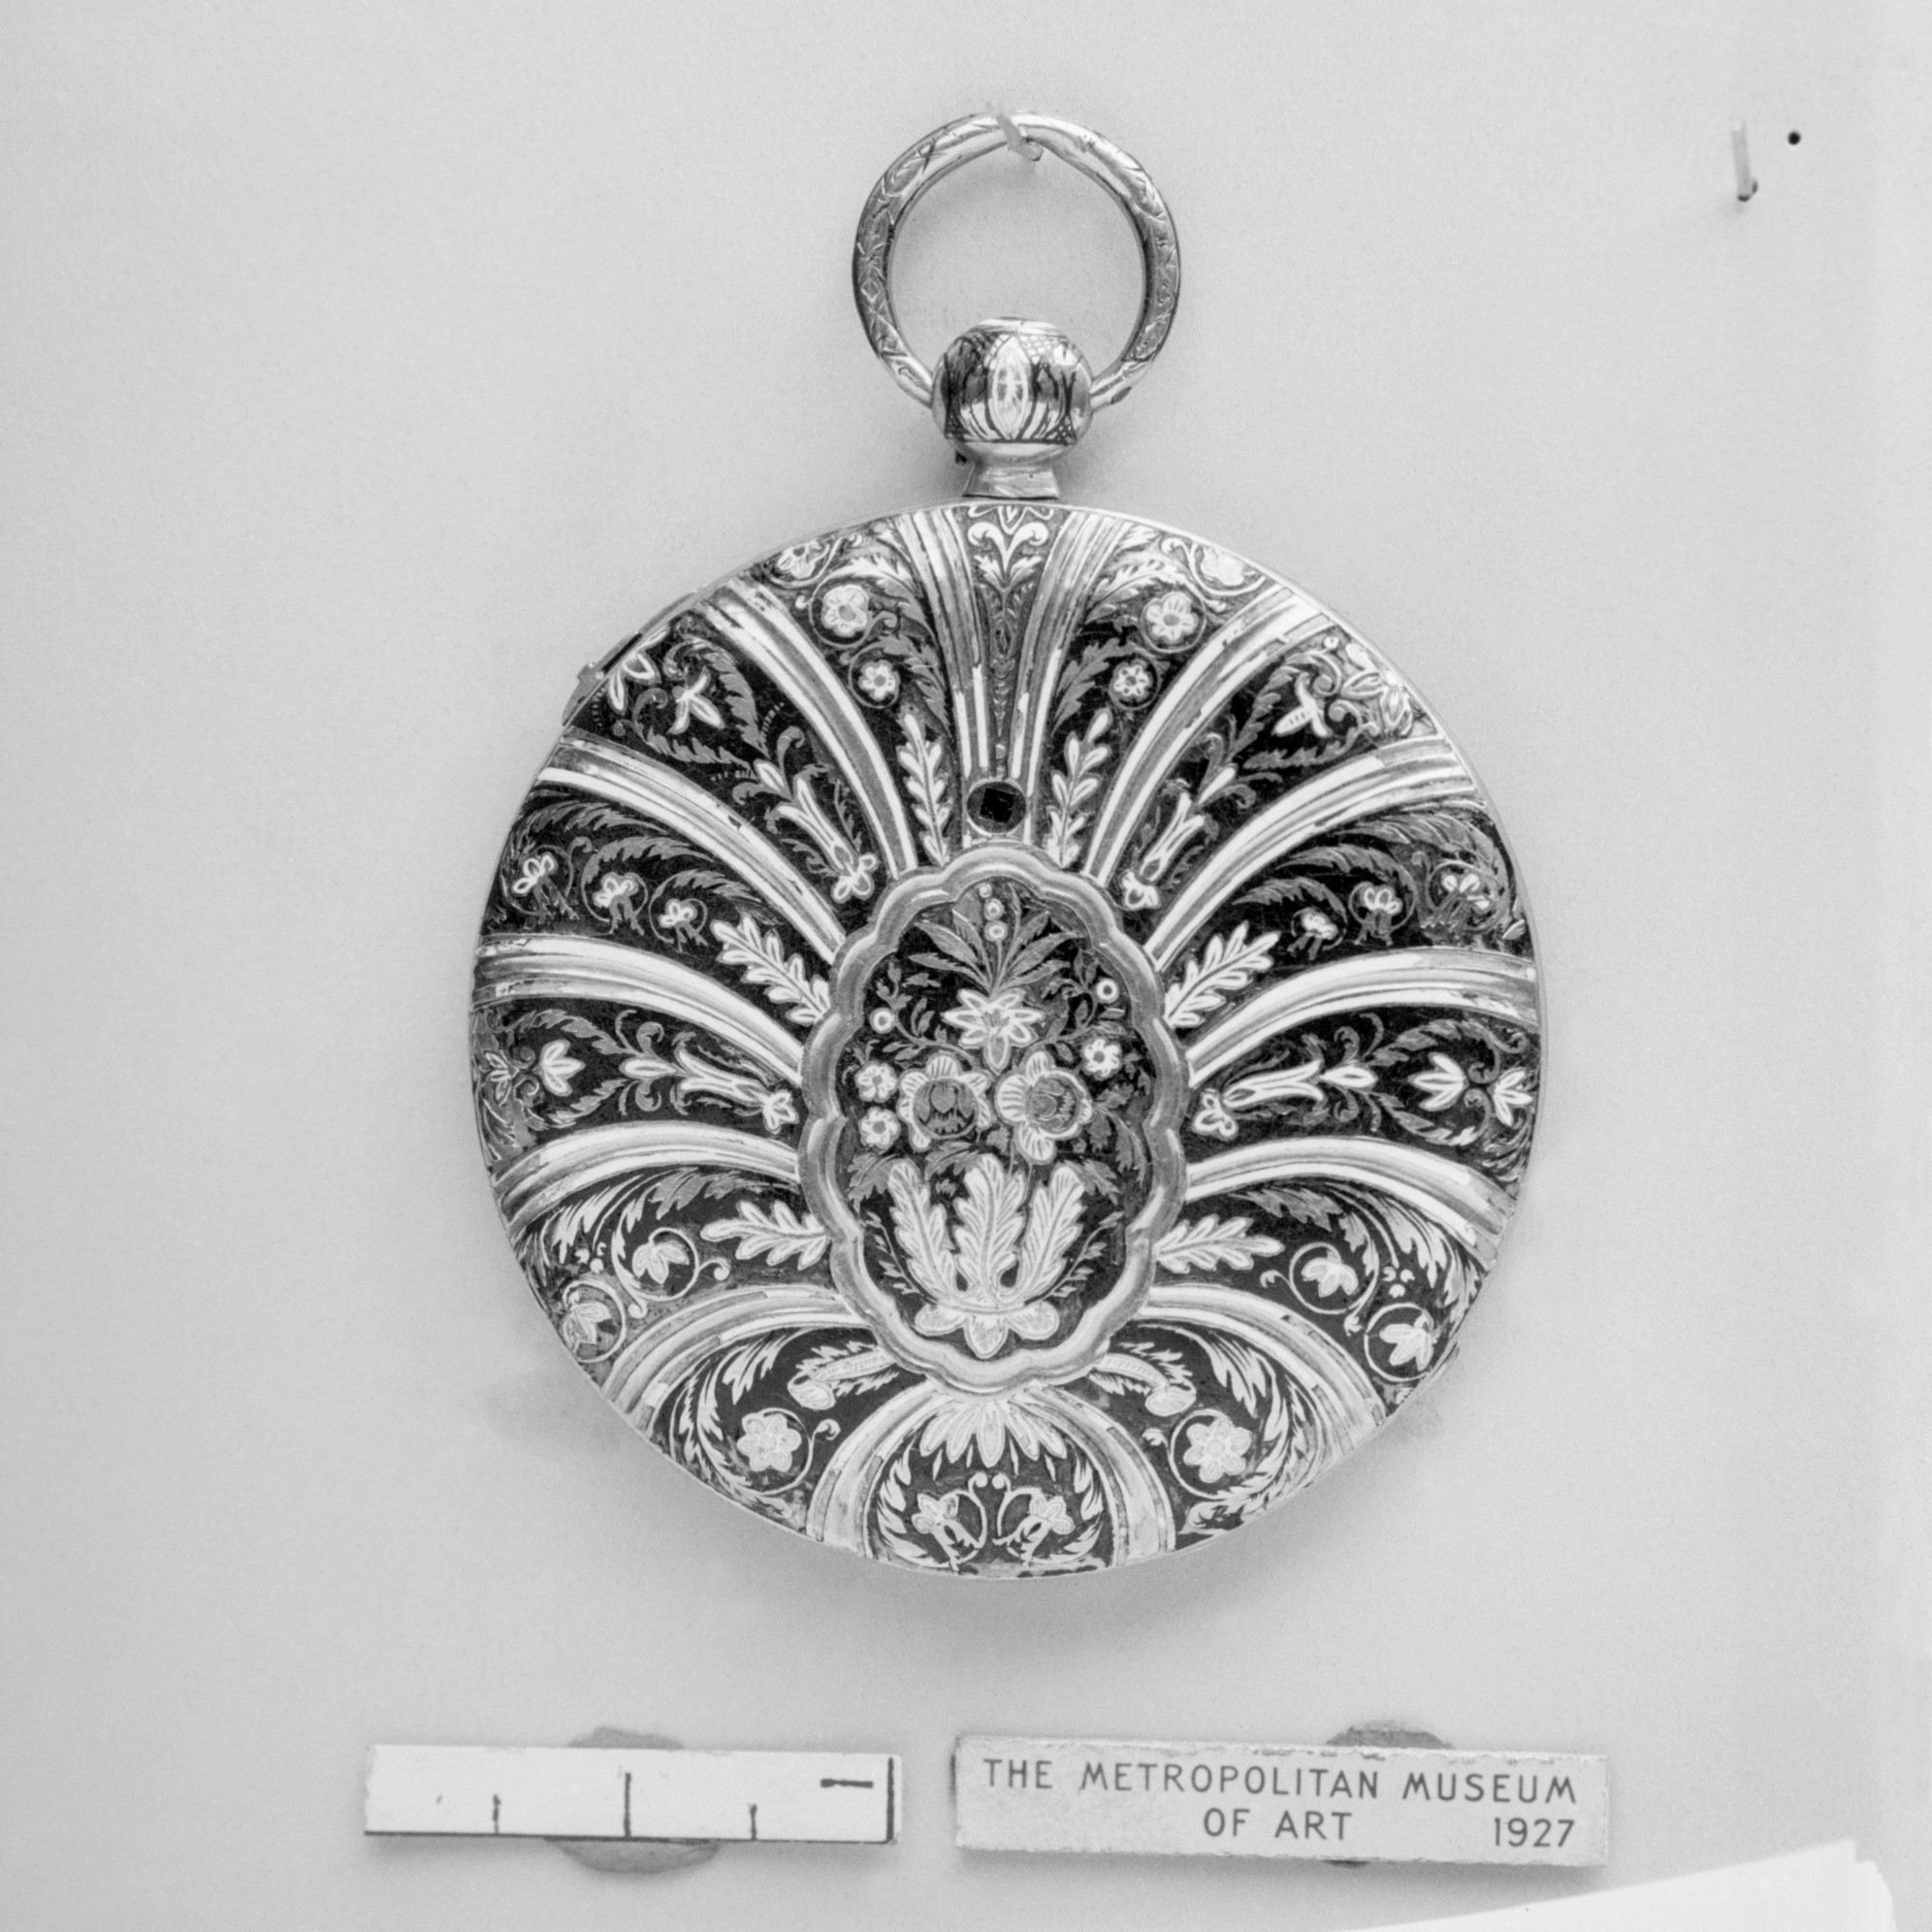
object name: watch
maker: f. pernetti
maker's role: maker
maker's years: 1800-1900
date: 1801-1900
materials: gold, silver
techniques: enamel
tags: flowers,leaves